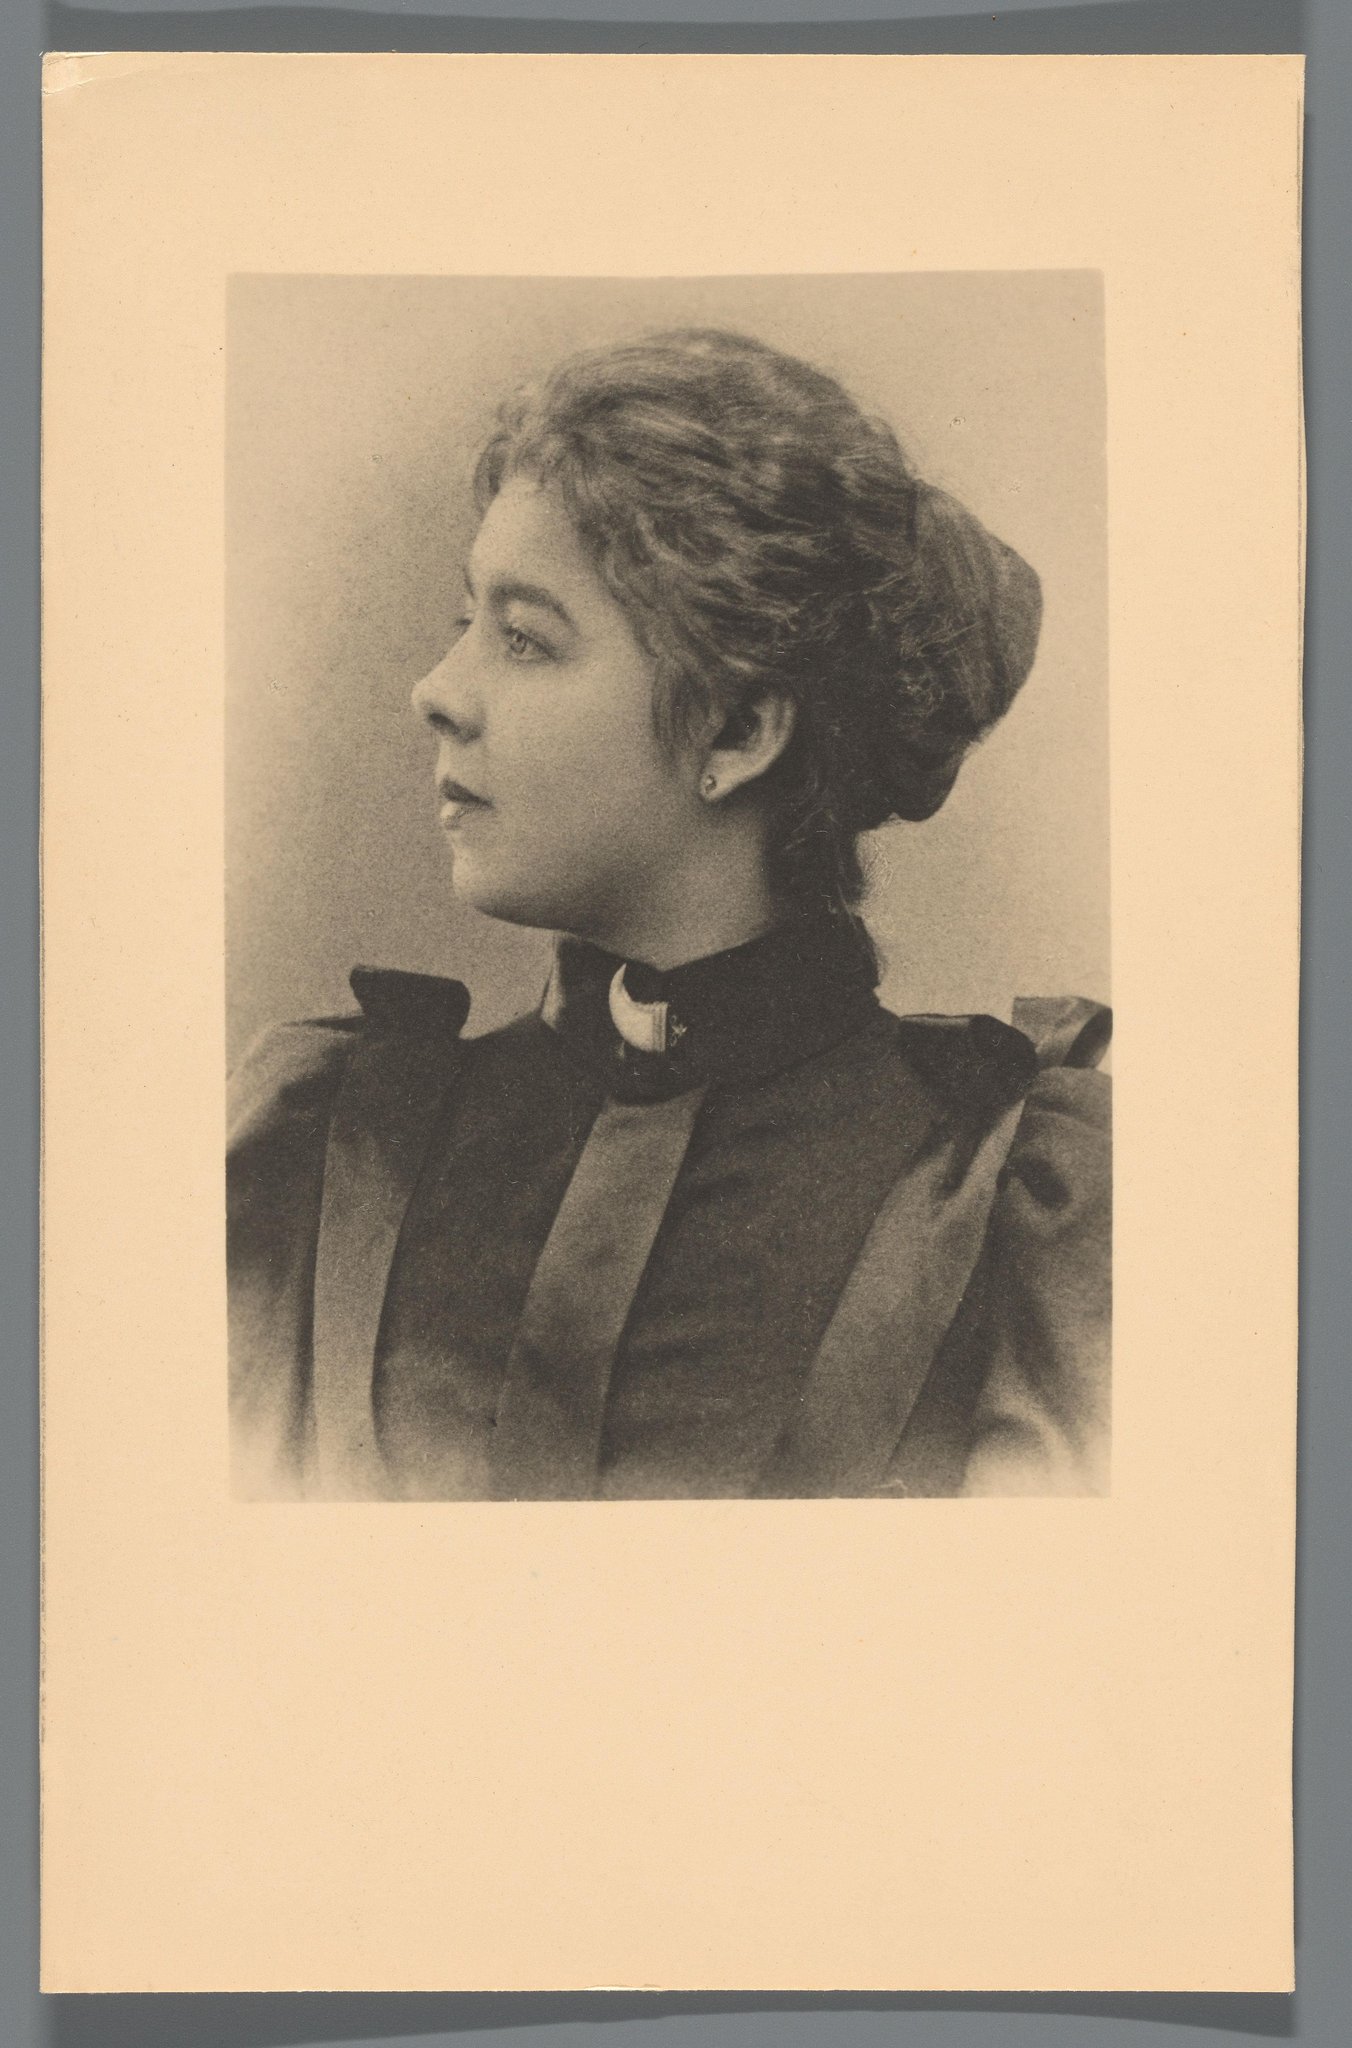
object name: photograph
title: Portret van A.C.M. Geertsema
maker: Anonymous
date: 1880-1910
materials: photographic support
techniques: photography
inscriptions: inscription: ‘R2489 / 3 cm’